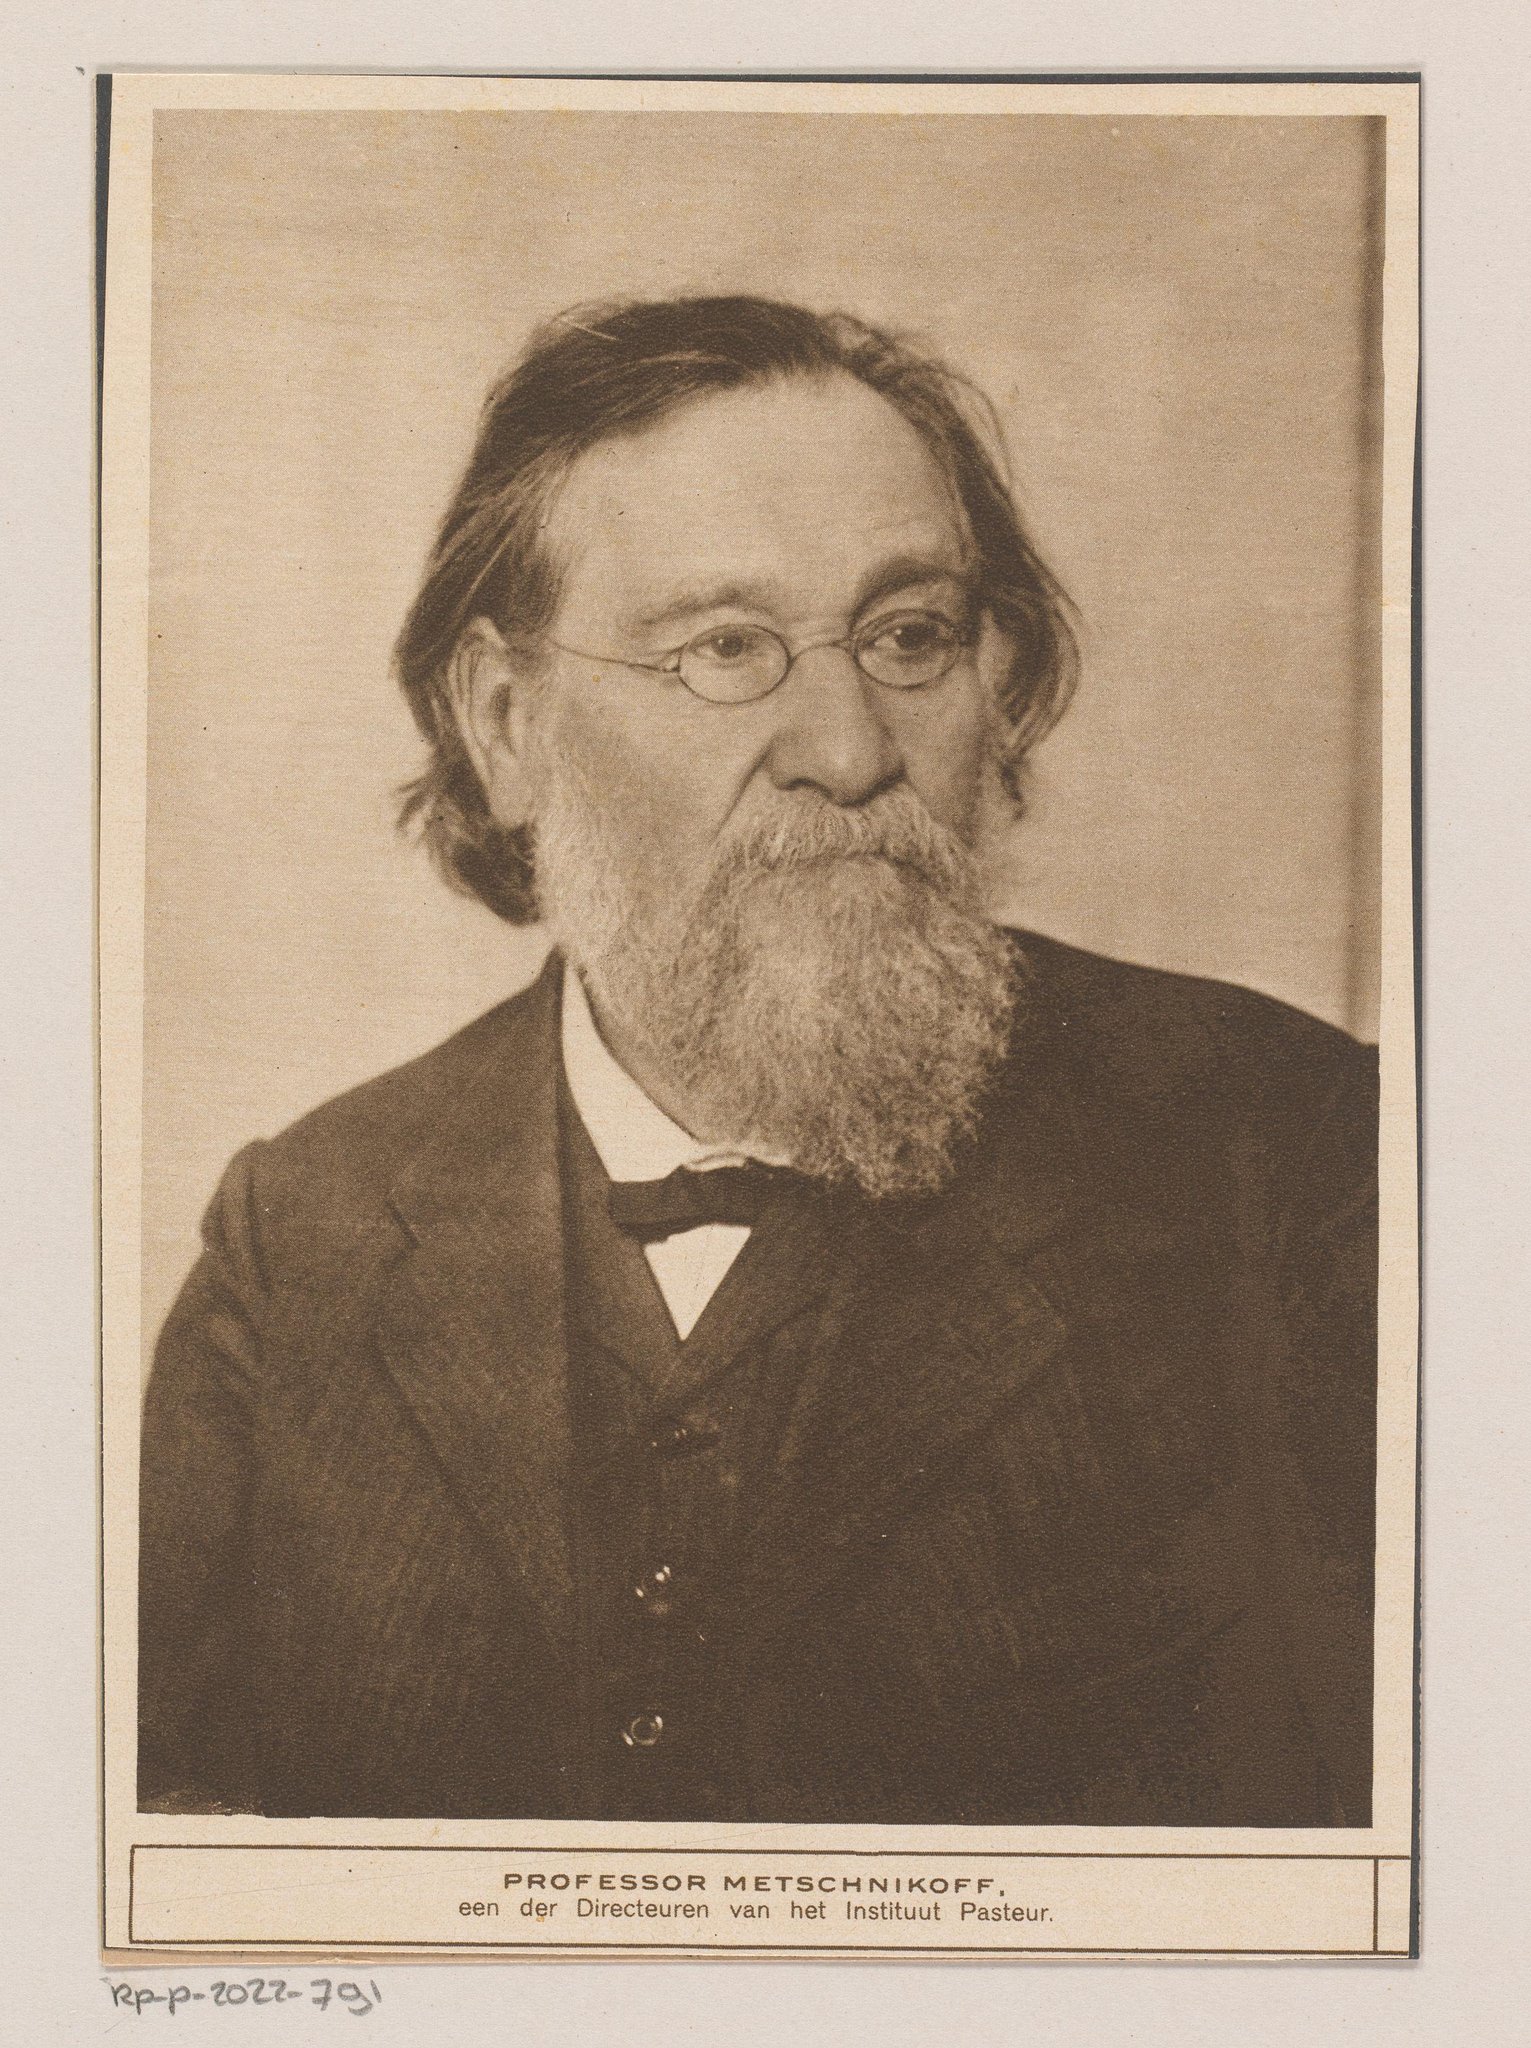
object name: photomechanical print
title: Portret van Ilya Mechnikov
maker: Anonymous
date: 1913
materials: paper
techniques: rotogravure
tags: paris, historical persons, biology (+ portrait of scholar, scientist)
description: Rotogravure uit: Panorama, geïllustreerd weekblad 1 (1913), nr. 21, 19 november 1913.